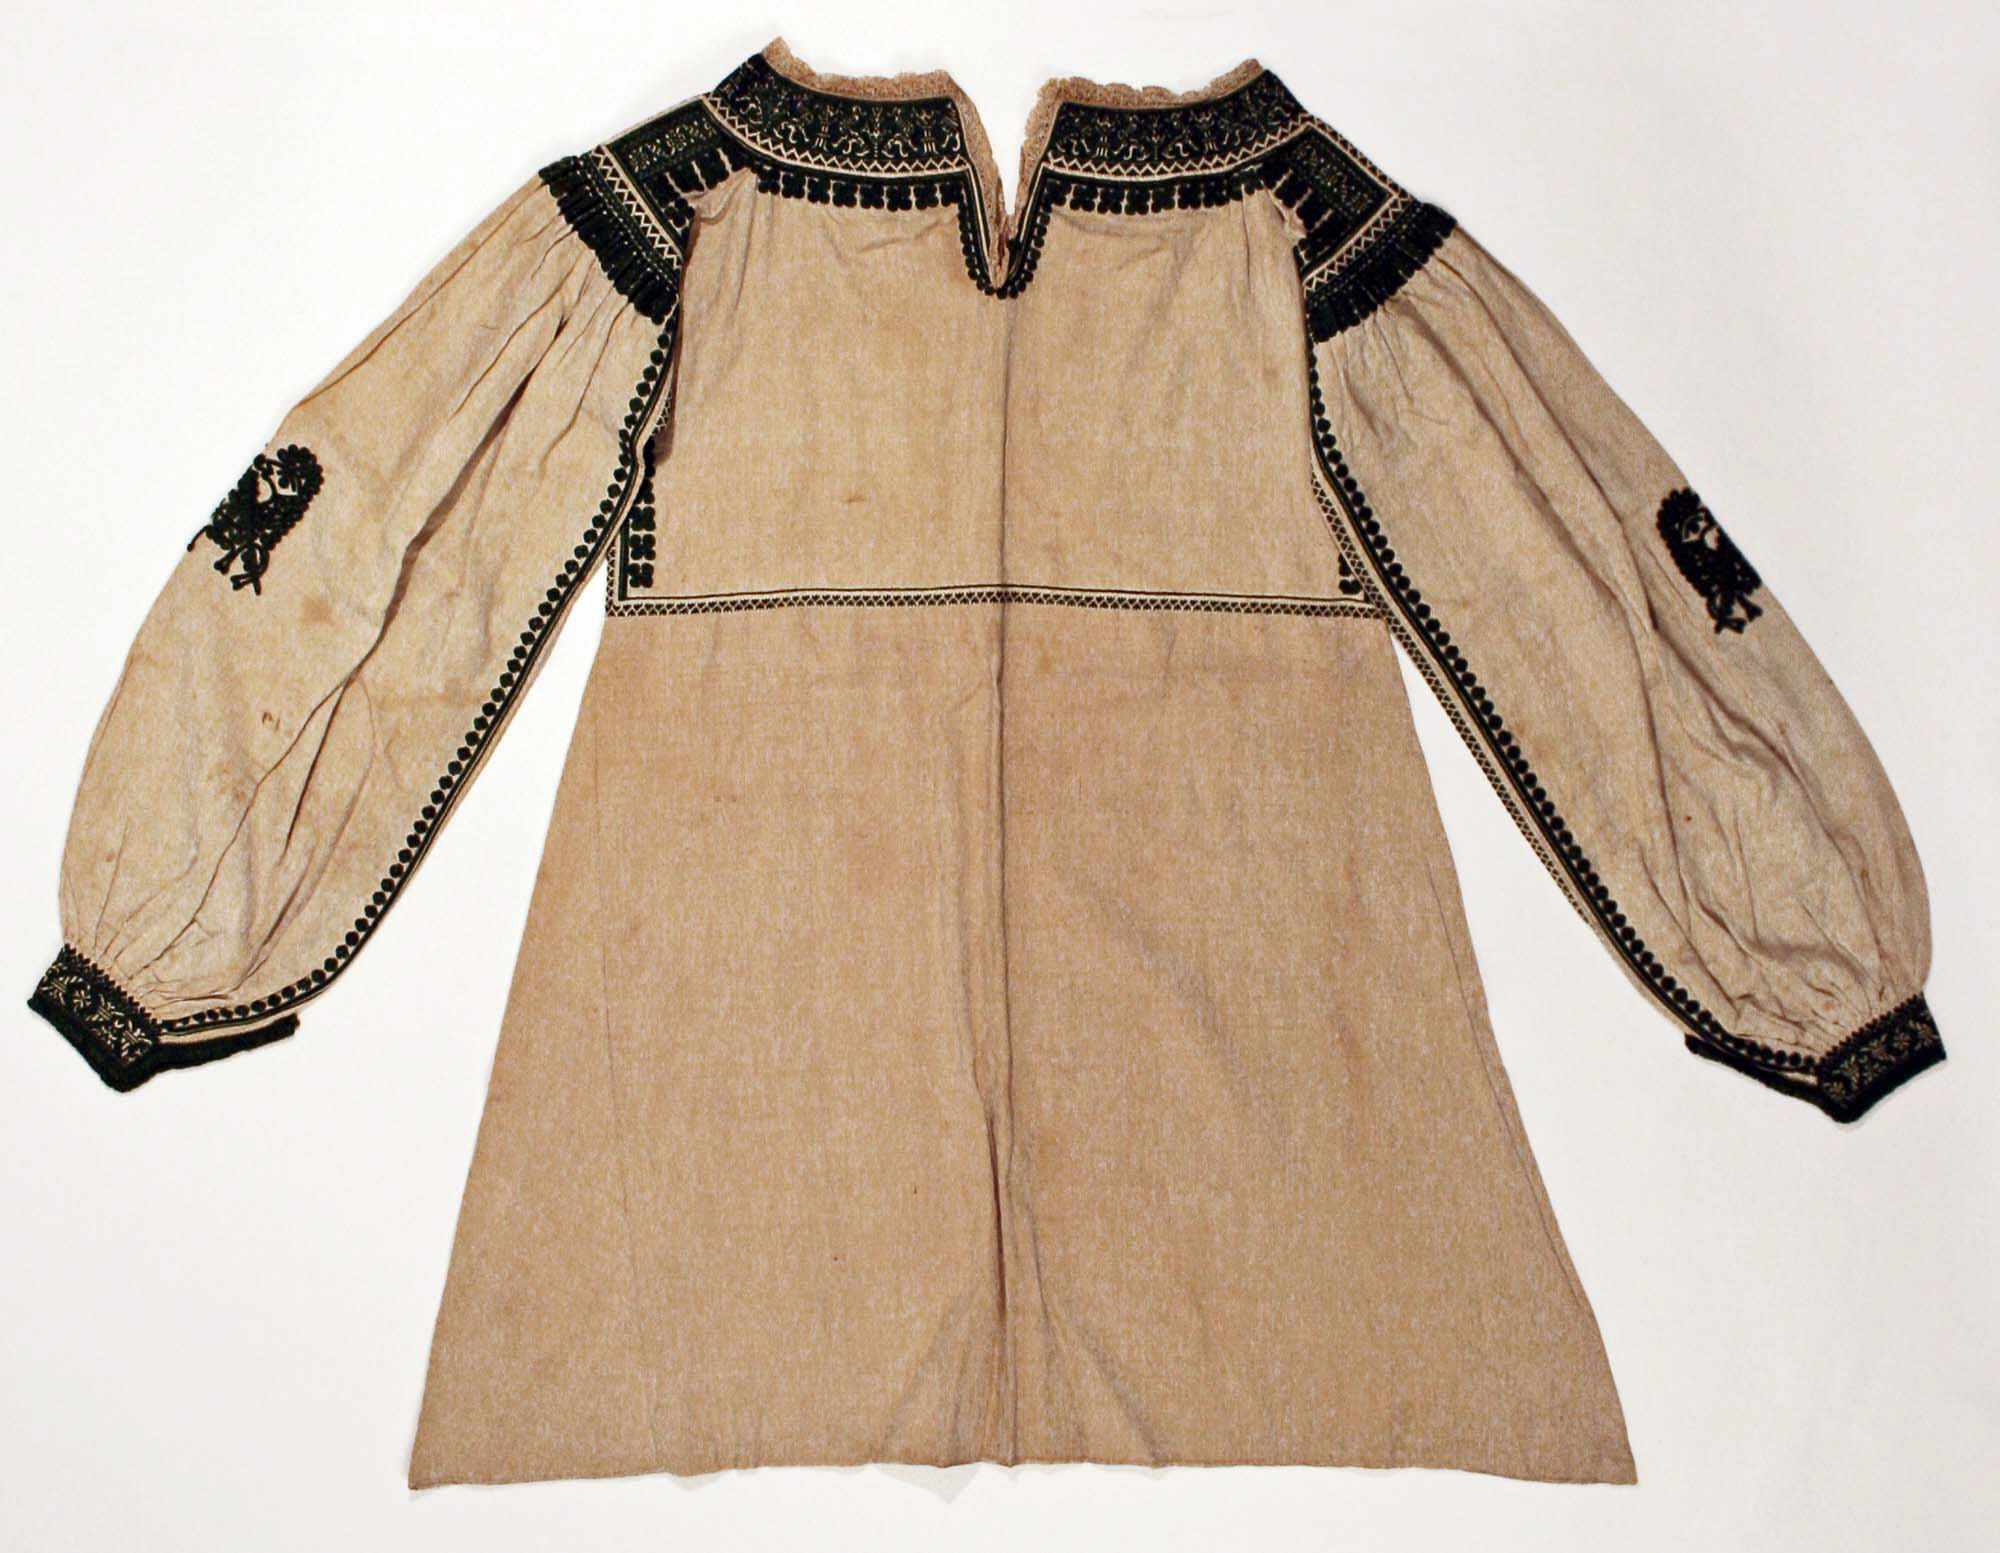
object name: shirt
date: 1801-1900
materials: linen